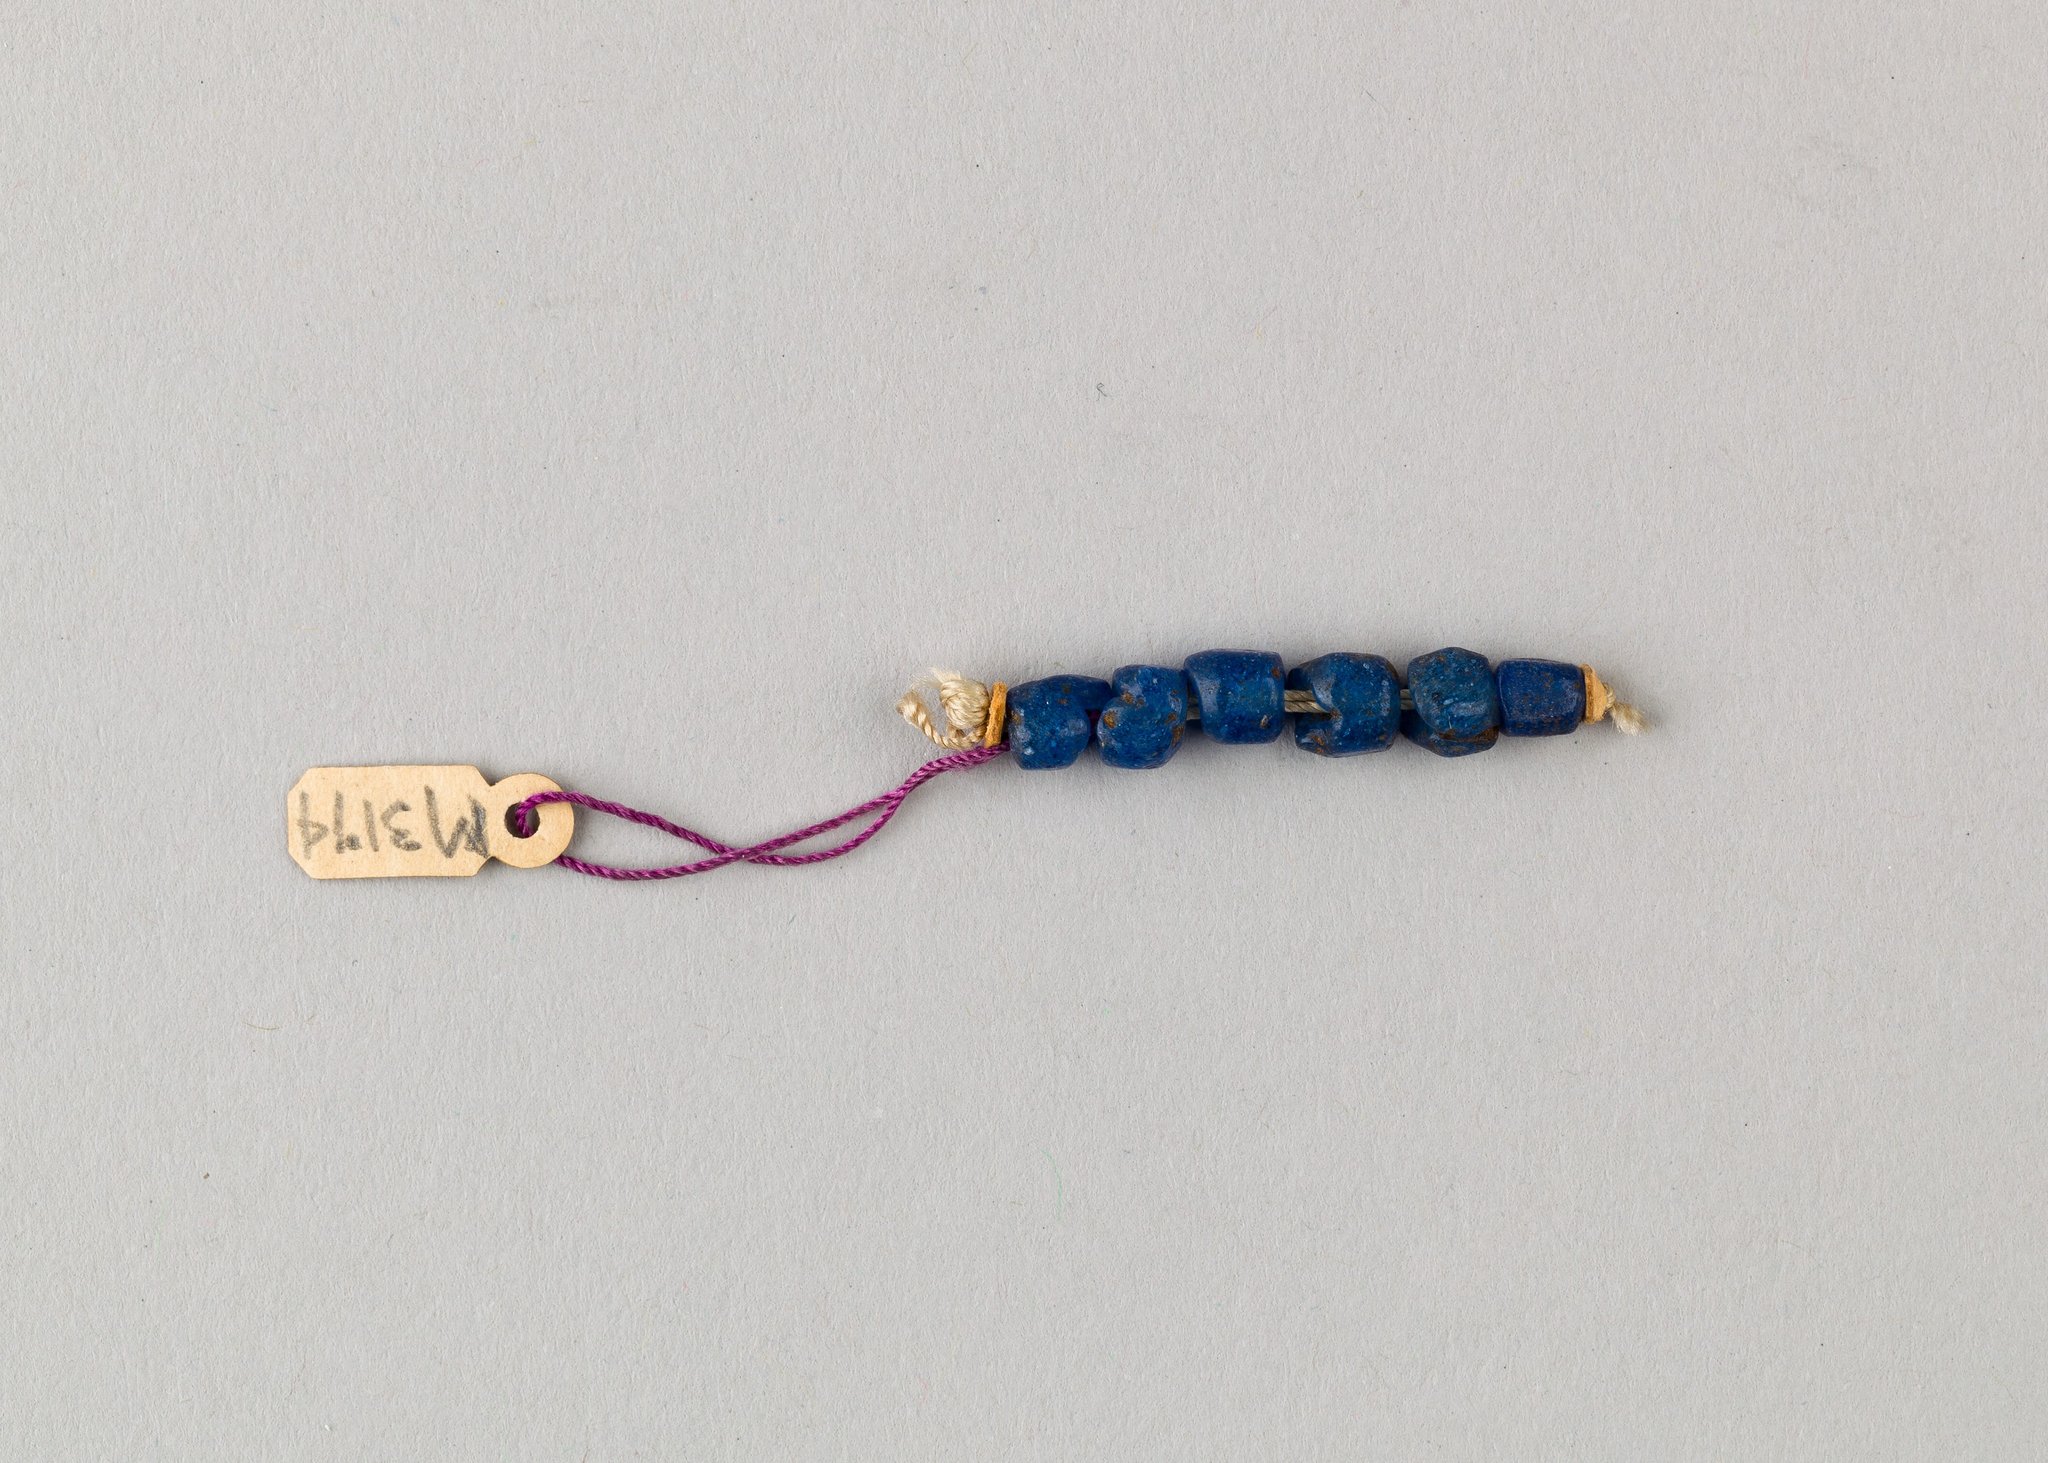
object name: bead, string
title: String of 6 beads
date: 1-400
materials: glass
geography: egypt